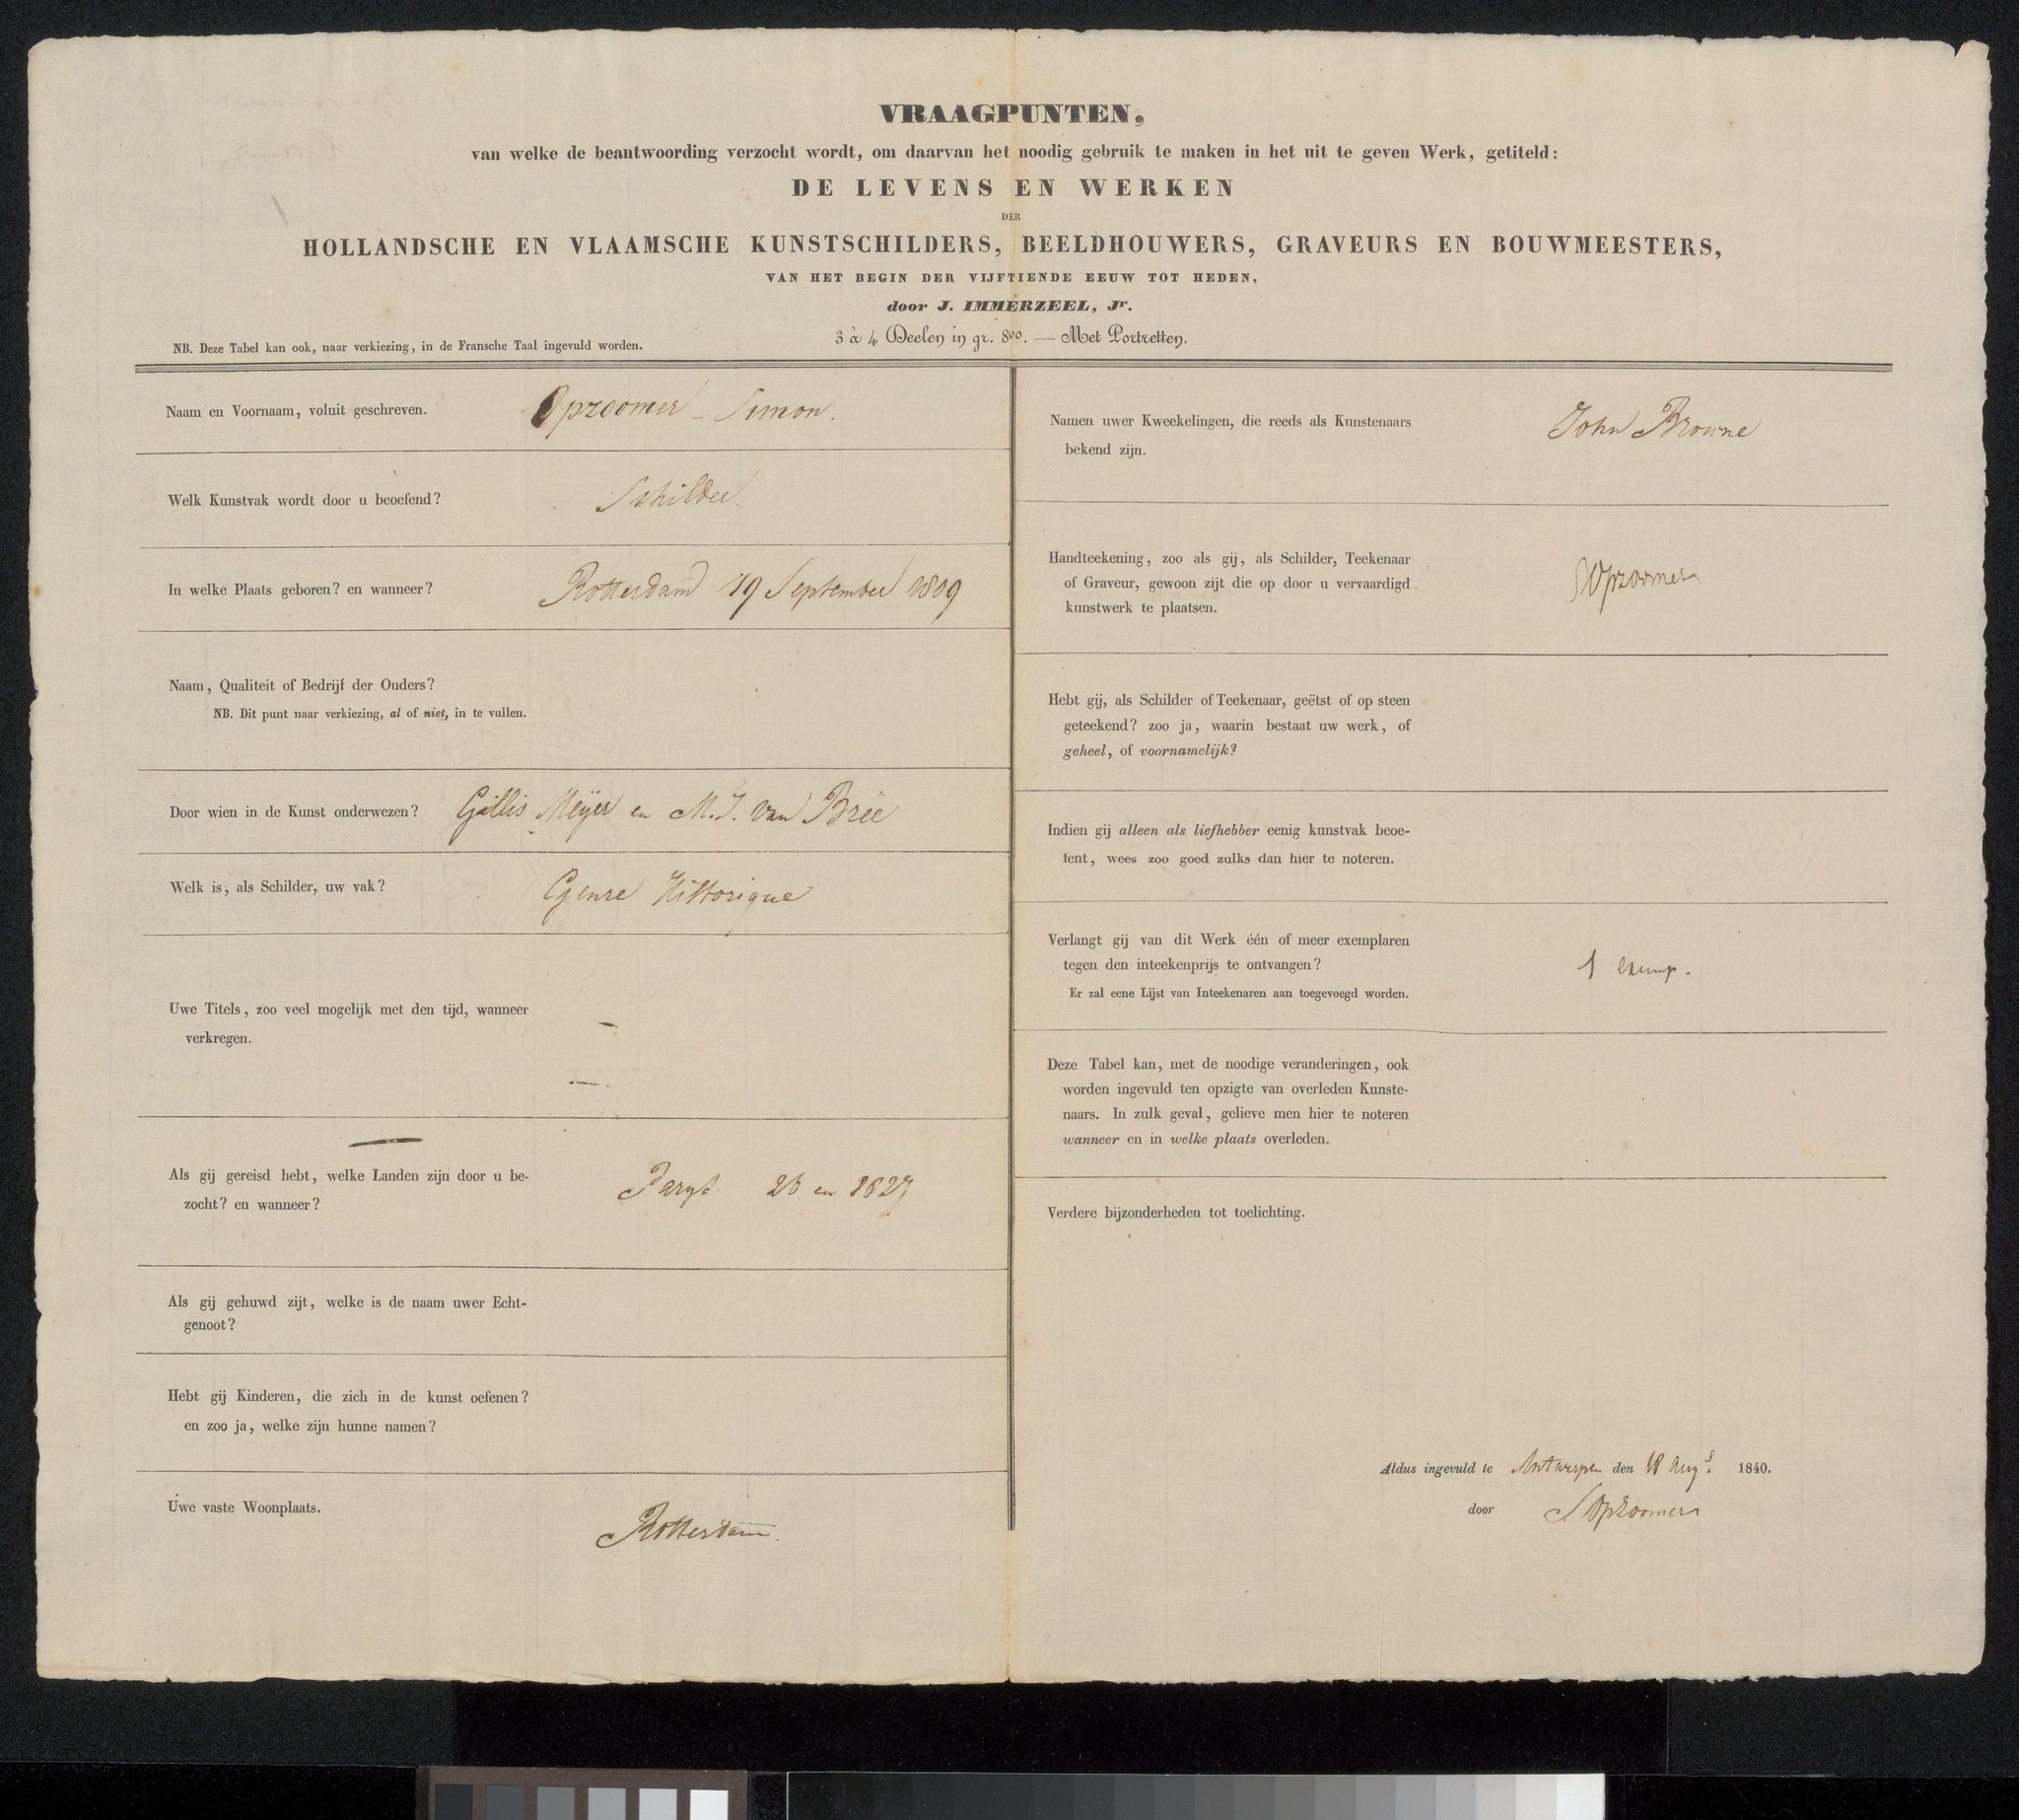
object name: questionnaire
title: Enquêteformulier ingevuld door Simon Opzoomer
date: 1840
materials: ink, paper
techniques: pen, printing, writing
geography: antwerp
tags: rotterdam, antwerp, painter, simon opzoomer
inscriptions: watermark, inscription: ‘Vraagpunten,/ van welke de beantwoording verzocht wordt, om daarvan het noodig gebruik te maken in het uit te geven Werk, getiteld: De levens en werken/ der Hollandsche en Vlaamsche kunstschilders, beeldhouwers,/ graveurs en bouwmeesters, van het begin der vijftiende eeuw tot heden/ door J. Immerzeel, Jr.’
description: Opgenomen in: Immerzeel, J. Jr., De levens en werken der Hollandsche en Vlaamsche kunstschilders, beeldhouwers, graveurs en bouwmeesters, van het begin der vijftiende eeuw tot heden, Amsterdam: J.C. van Kesteren, 1842-1843.